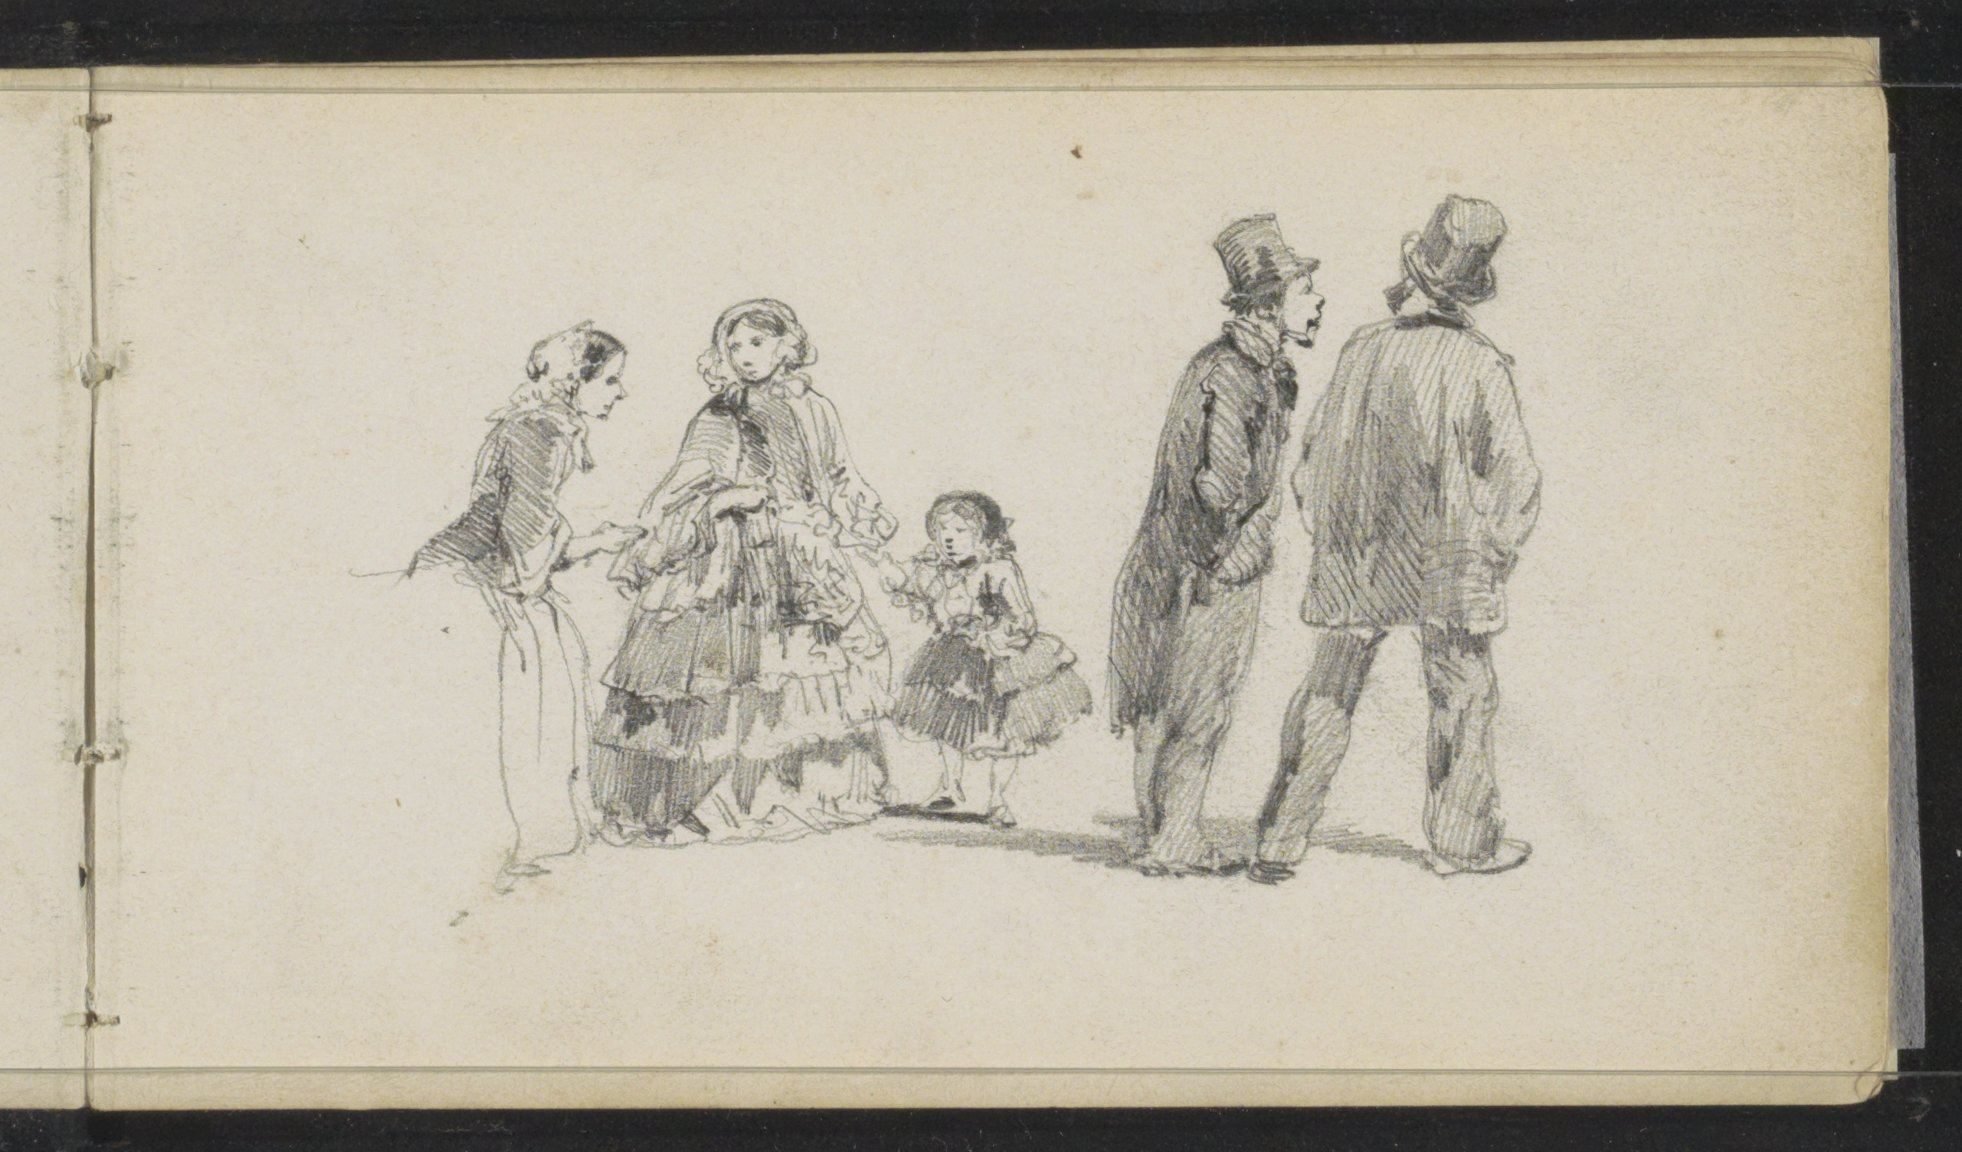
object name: sketchbook leaf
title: Vrouwen met kind en twee mannen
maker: cornelis springer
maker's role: draughtsman, painter, print maker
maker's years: 1817-1891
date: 1860-1866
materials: paper, pencil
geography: netherlands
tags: adult woman, child (+ female (human being) (not to be used where -aa- is prescribed)), adult man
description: Links twee vrouwen en een meisje. Rechts twee mannen met hoge hoeden. Blad 2 recto uit een schetsboek met 44 bladen.